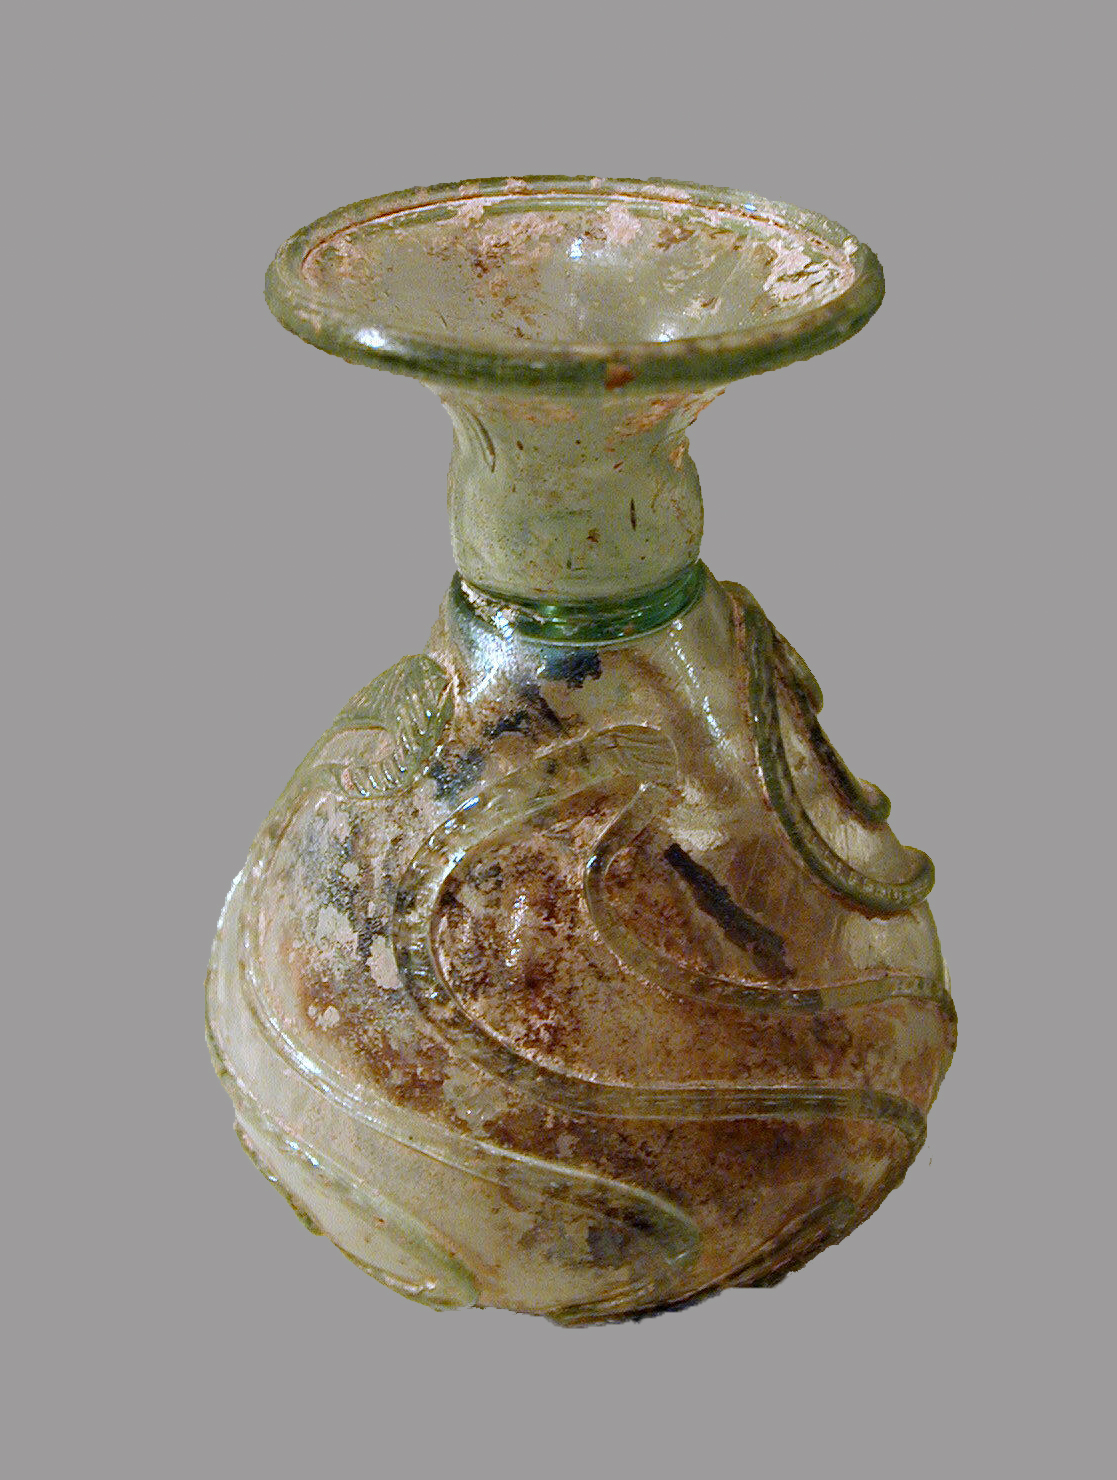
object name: sprinkler flask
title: Glass sprinkler flask with snake-thread decroation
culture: roman, syrian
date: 201-300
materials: glass